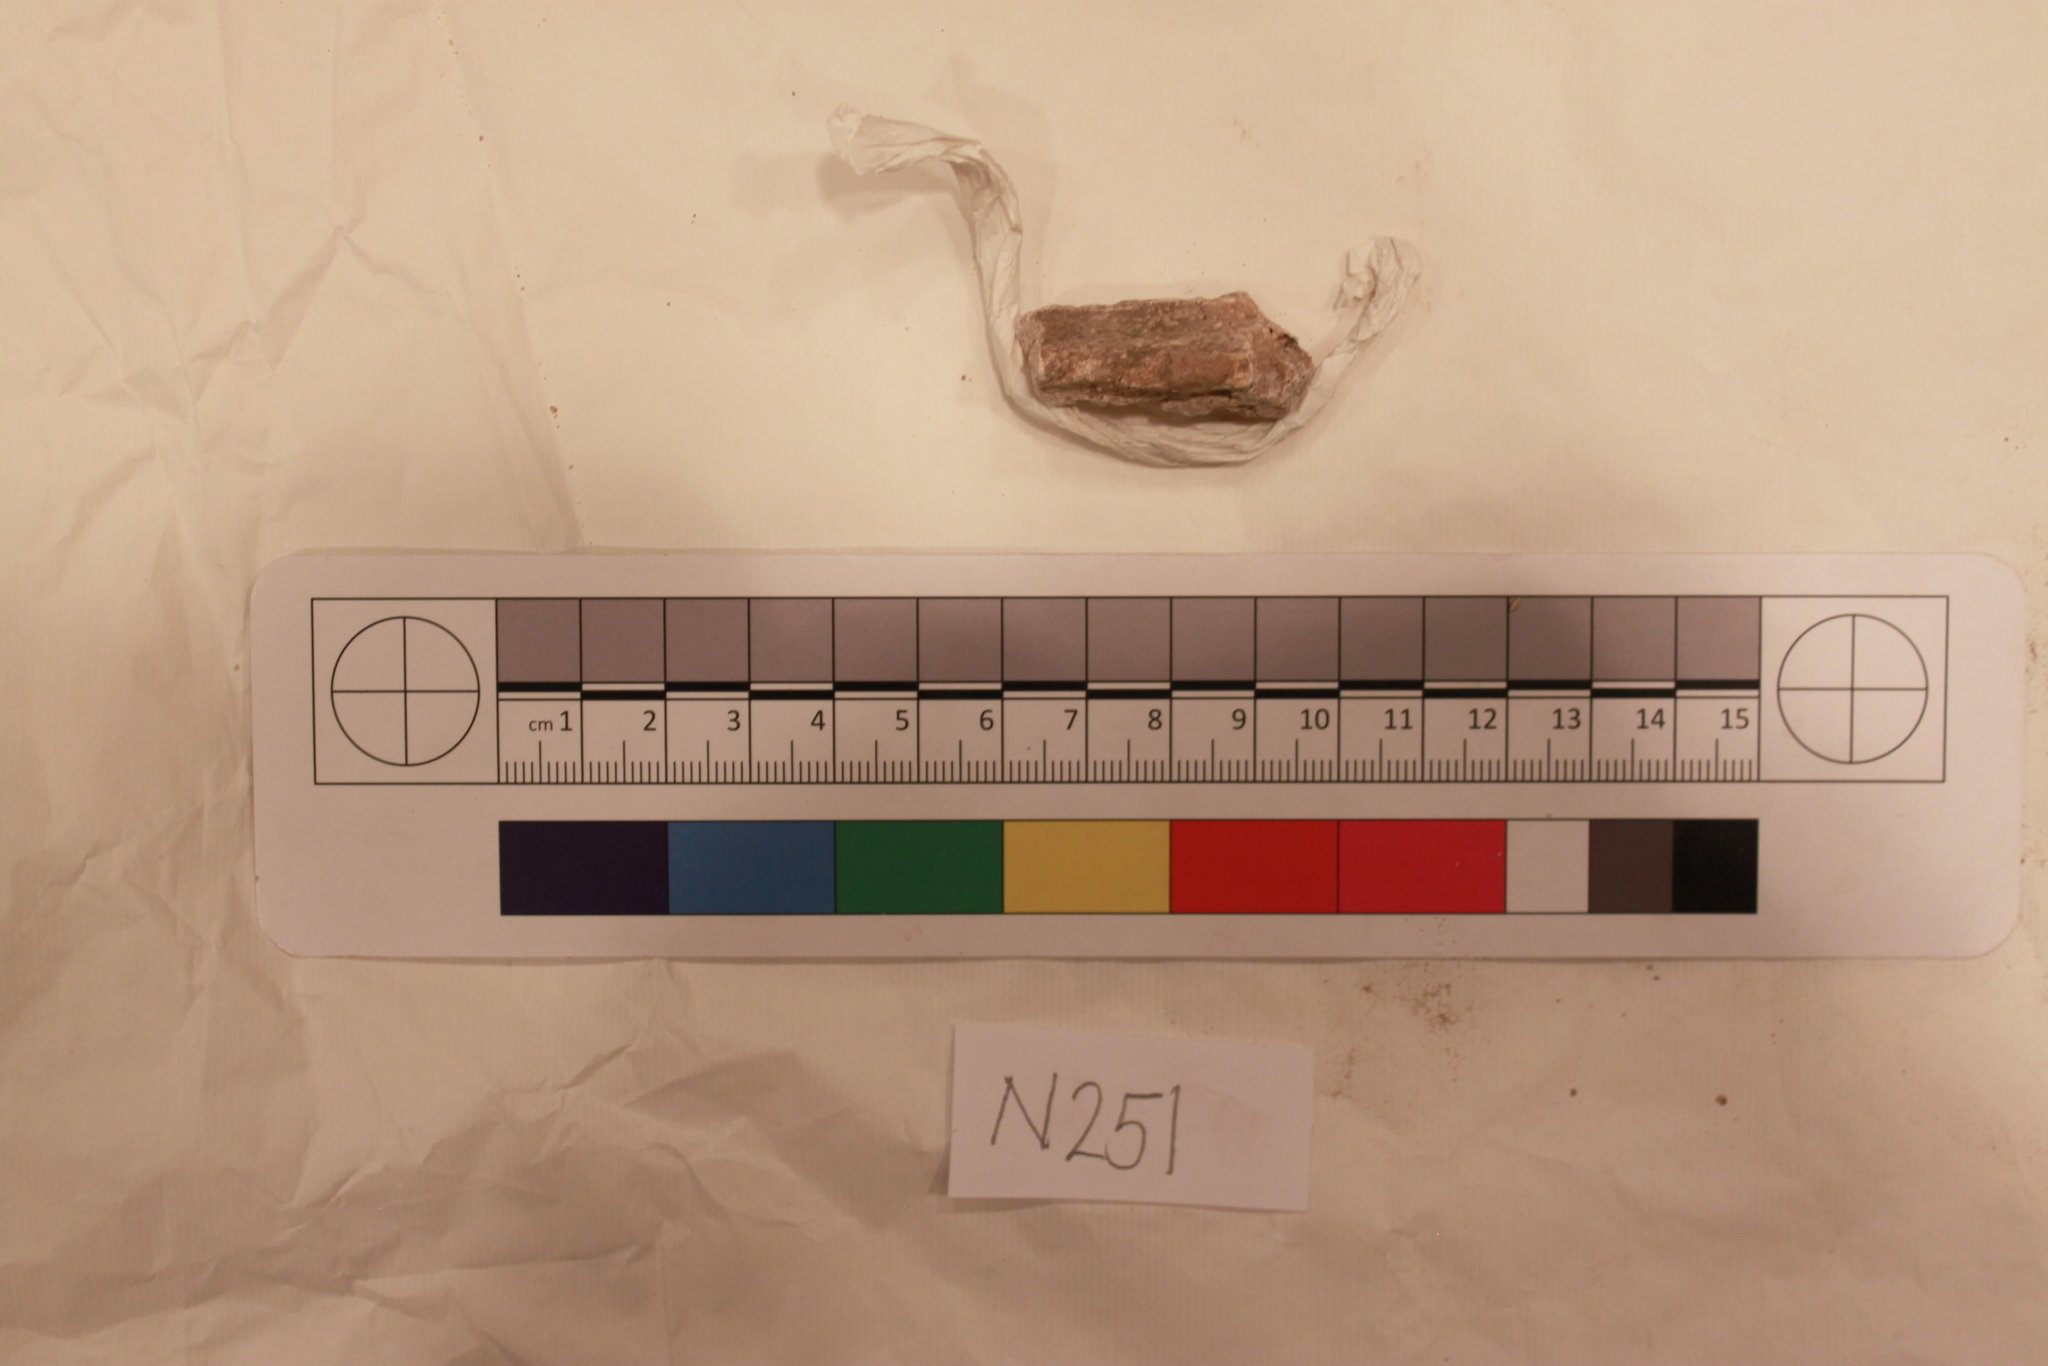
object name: fragment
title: Stucco Fragment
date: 701-1200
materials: plaster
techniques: carving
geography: iran